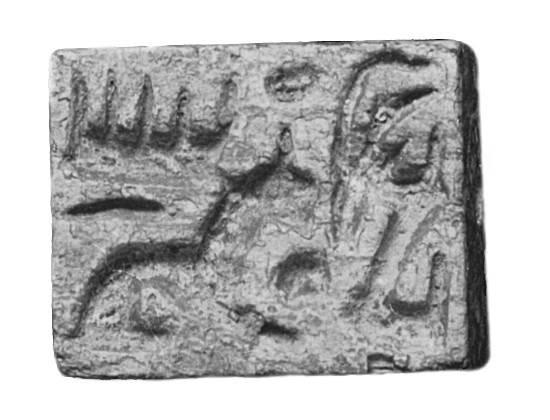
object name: amulet, plaque, oval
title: Plaque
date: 1295-1070 BCE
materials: stone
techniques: glazing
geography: egypt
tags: hieroglyphs